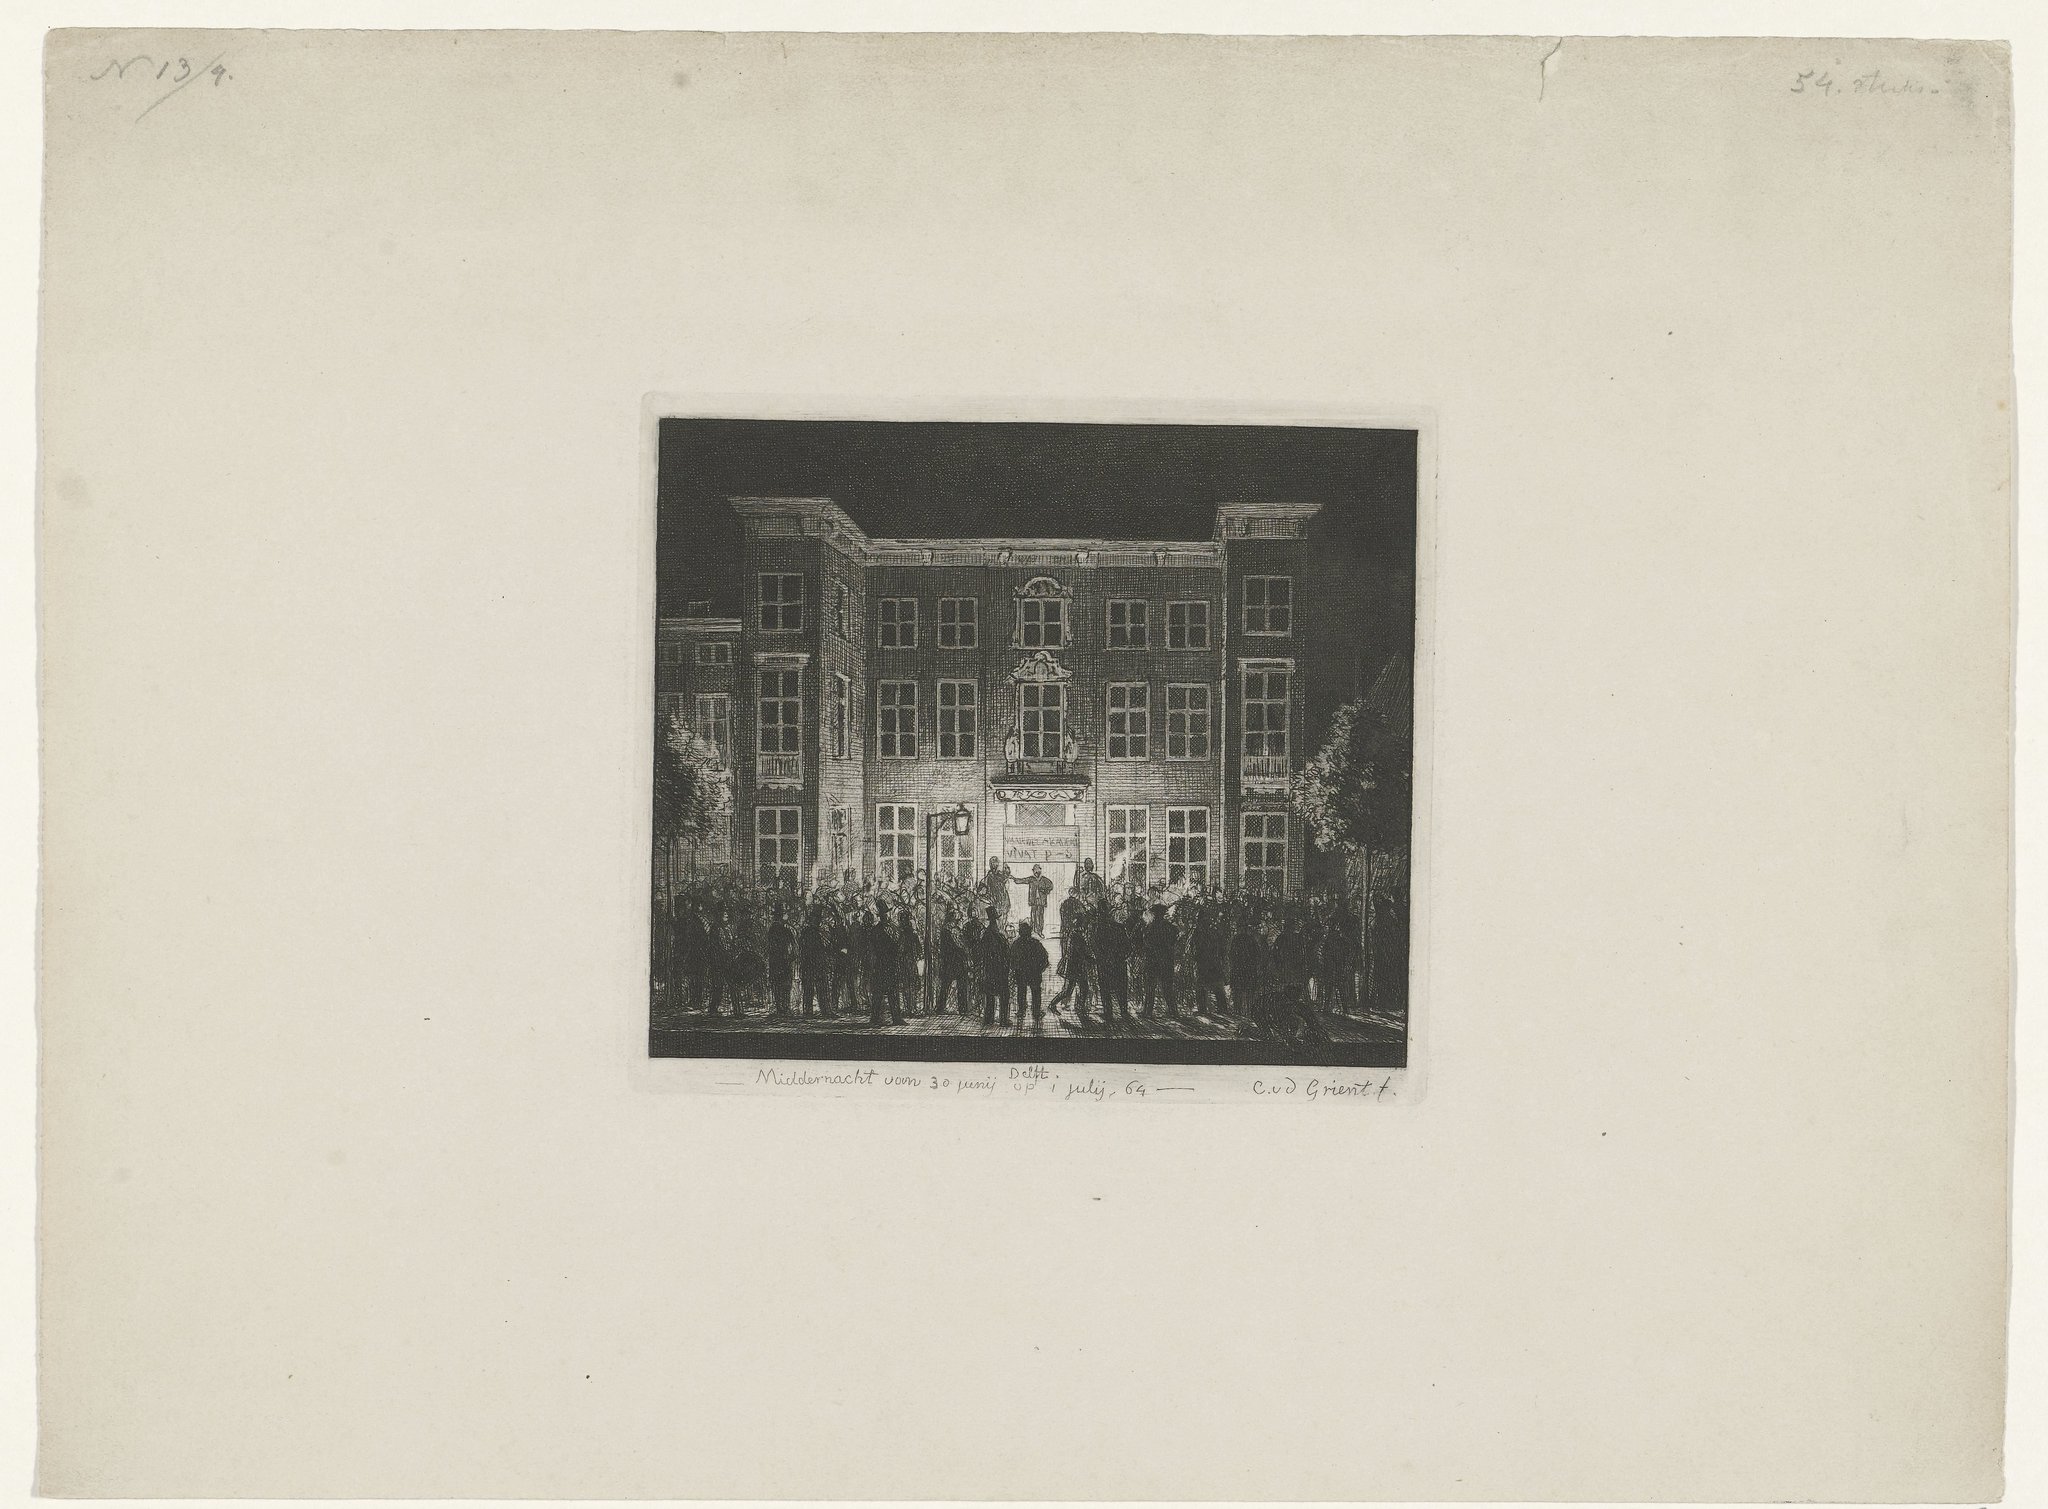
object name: print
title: Begrafenis van de Delftsche academie, 30 juni 1864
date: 1864-1866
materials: paper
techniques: drypoint, etching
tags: university, funerary ceremonial, delft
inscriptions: collector's mark: Lugt 2228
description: Illuminatie van een huis te Delft, middernacht van 30 juni op 1 juli 1864. Een groep studenten verzameld voor een verlicht huis aan een gracht. Boven de deur van het huis een bord met het opschrift 'Akademia VIVAT P - S'. Bij de naamsverandering van de Delftsche Akademie in de Delftsche Polytechnische School.